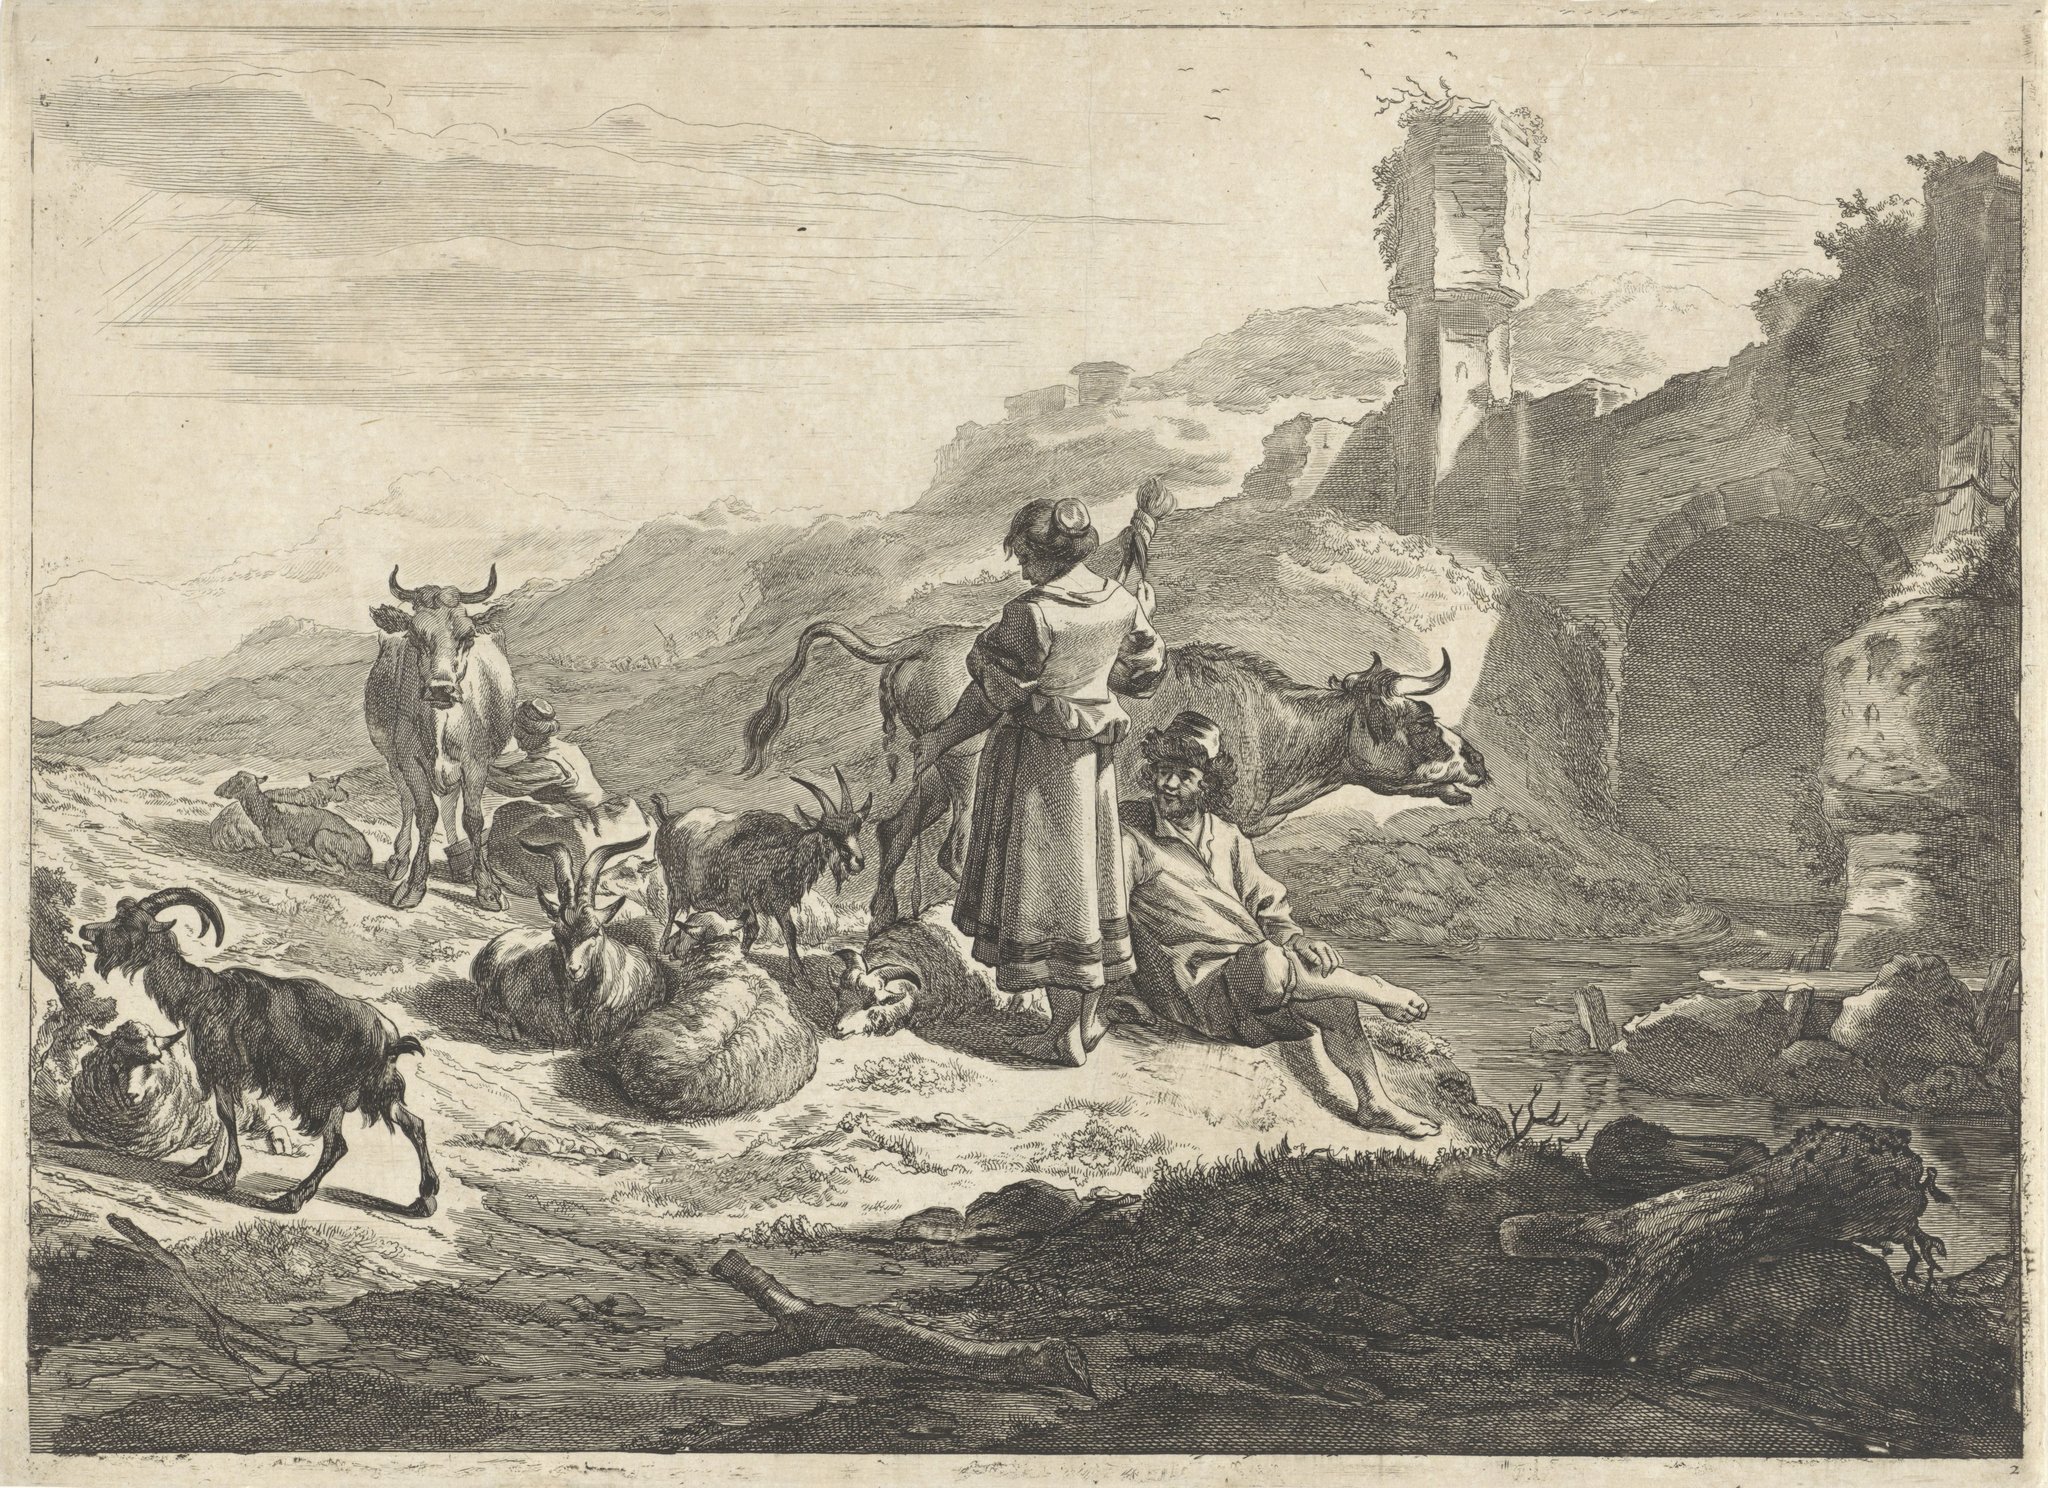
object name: print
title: Staande spinster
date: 1638-1658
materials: paper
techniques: engraving, etching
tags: landscapes, herding, herdsman, herdswoman, shepherd, shepherdess, cowherd, etc., cattle, spinning (manufacture of yarn), milking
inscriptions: collector's mark: Lugt 2228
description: In een glooiend landschap bij een ruïne zit een herder te rusten tussen zijn vee. Naast hem staat een vrouw wol te spinnen, en op de achtergrond melkt een tweede vrouw een koe.